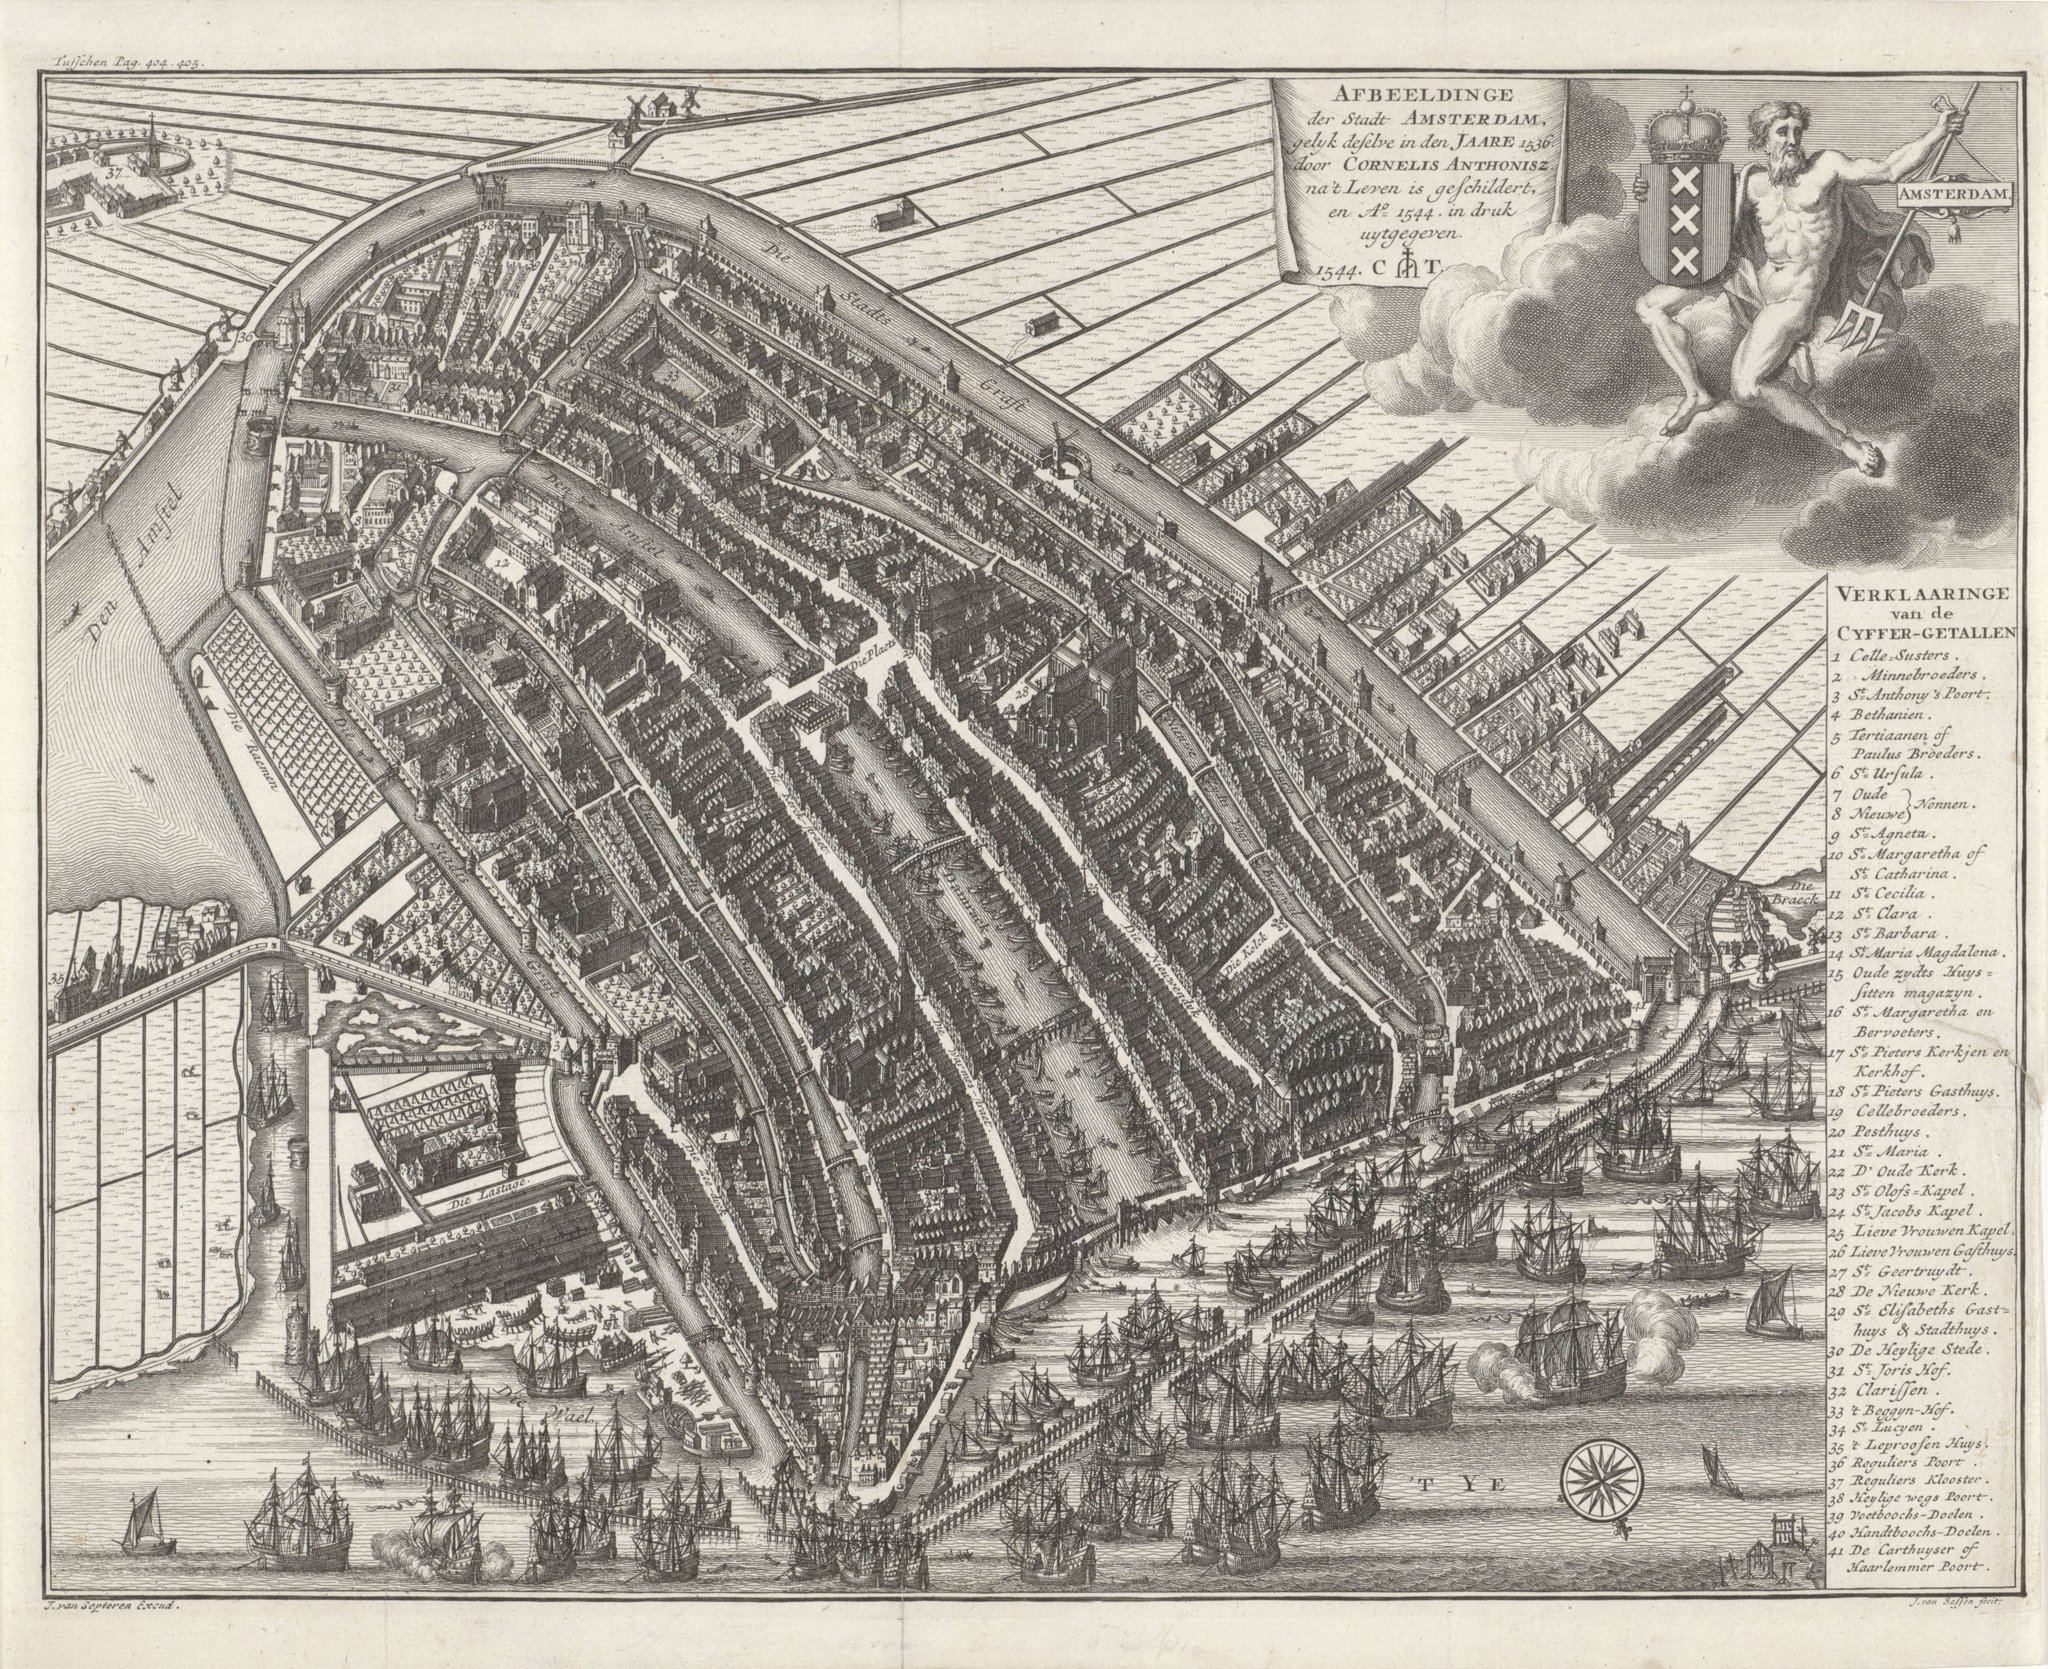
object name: book illustration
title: Kaart van Amsterdam in vogelvlucht, anno 1544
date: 1544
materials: paper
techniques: engraving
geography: amsterdam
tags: specific aspects, allegorical aspects of neptune; neptune as patron, maps of cities, amsterdam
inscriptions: collector's mark: Lugt 2760, collector's mark: Lugt 2166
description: Kaart van Amsterdam in vogelvlucht (oriëntatie zuidzuidwest boven) uit het jaar 1544 met veel schepen. Rechtsboven zit Neptunus op een wolk met zijn arm om het wapen van Amsterdam.